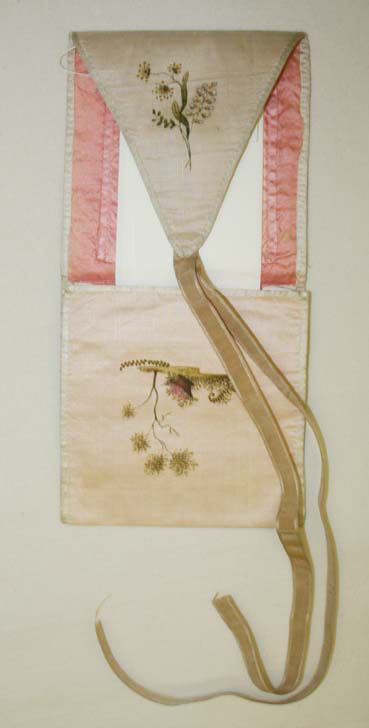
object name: purse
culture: french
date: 1780-1790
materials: silk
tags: plants